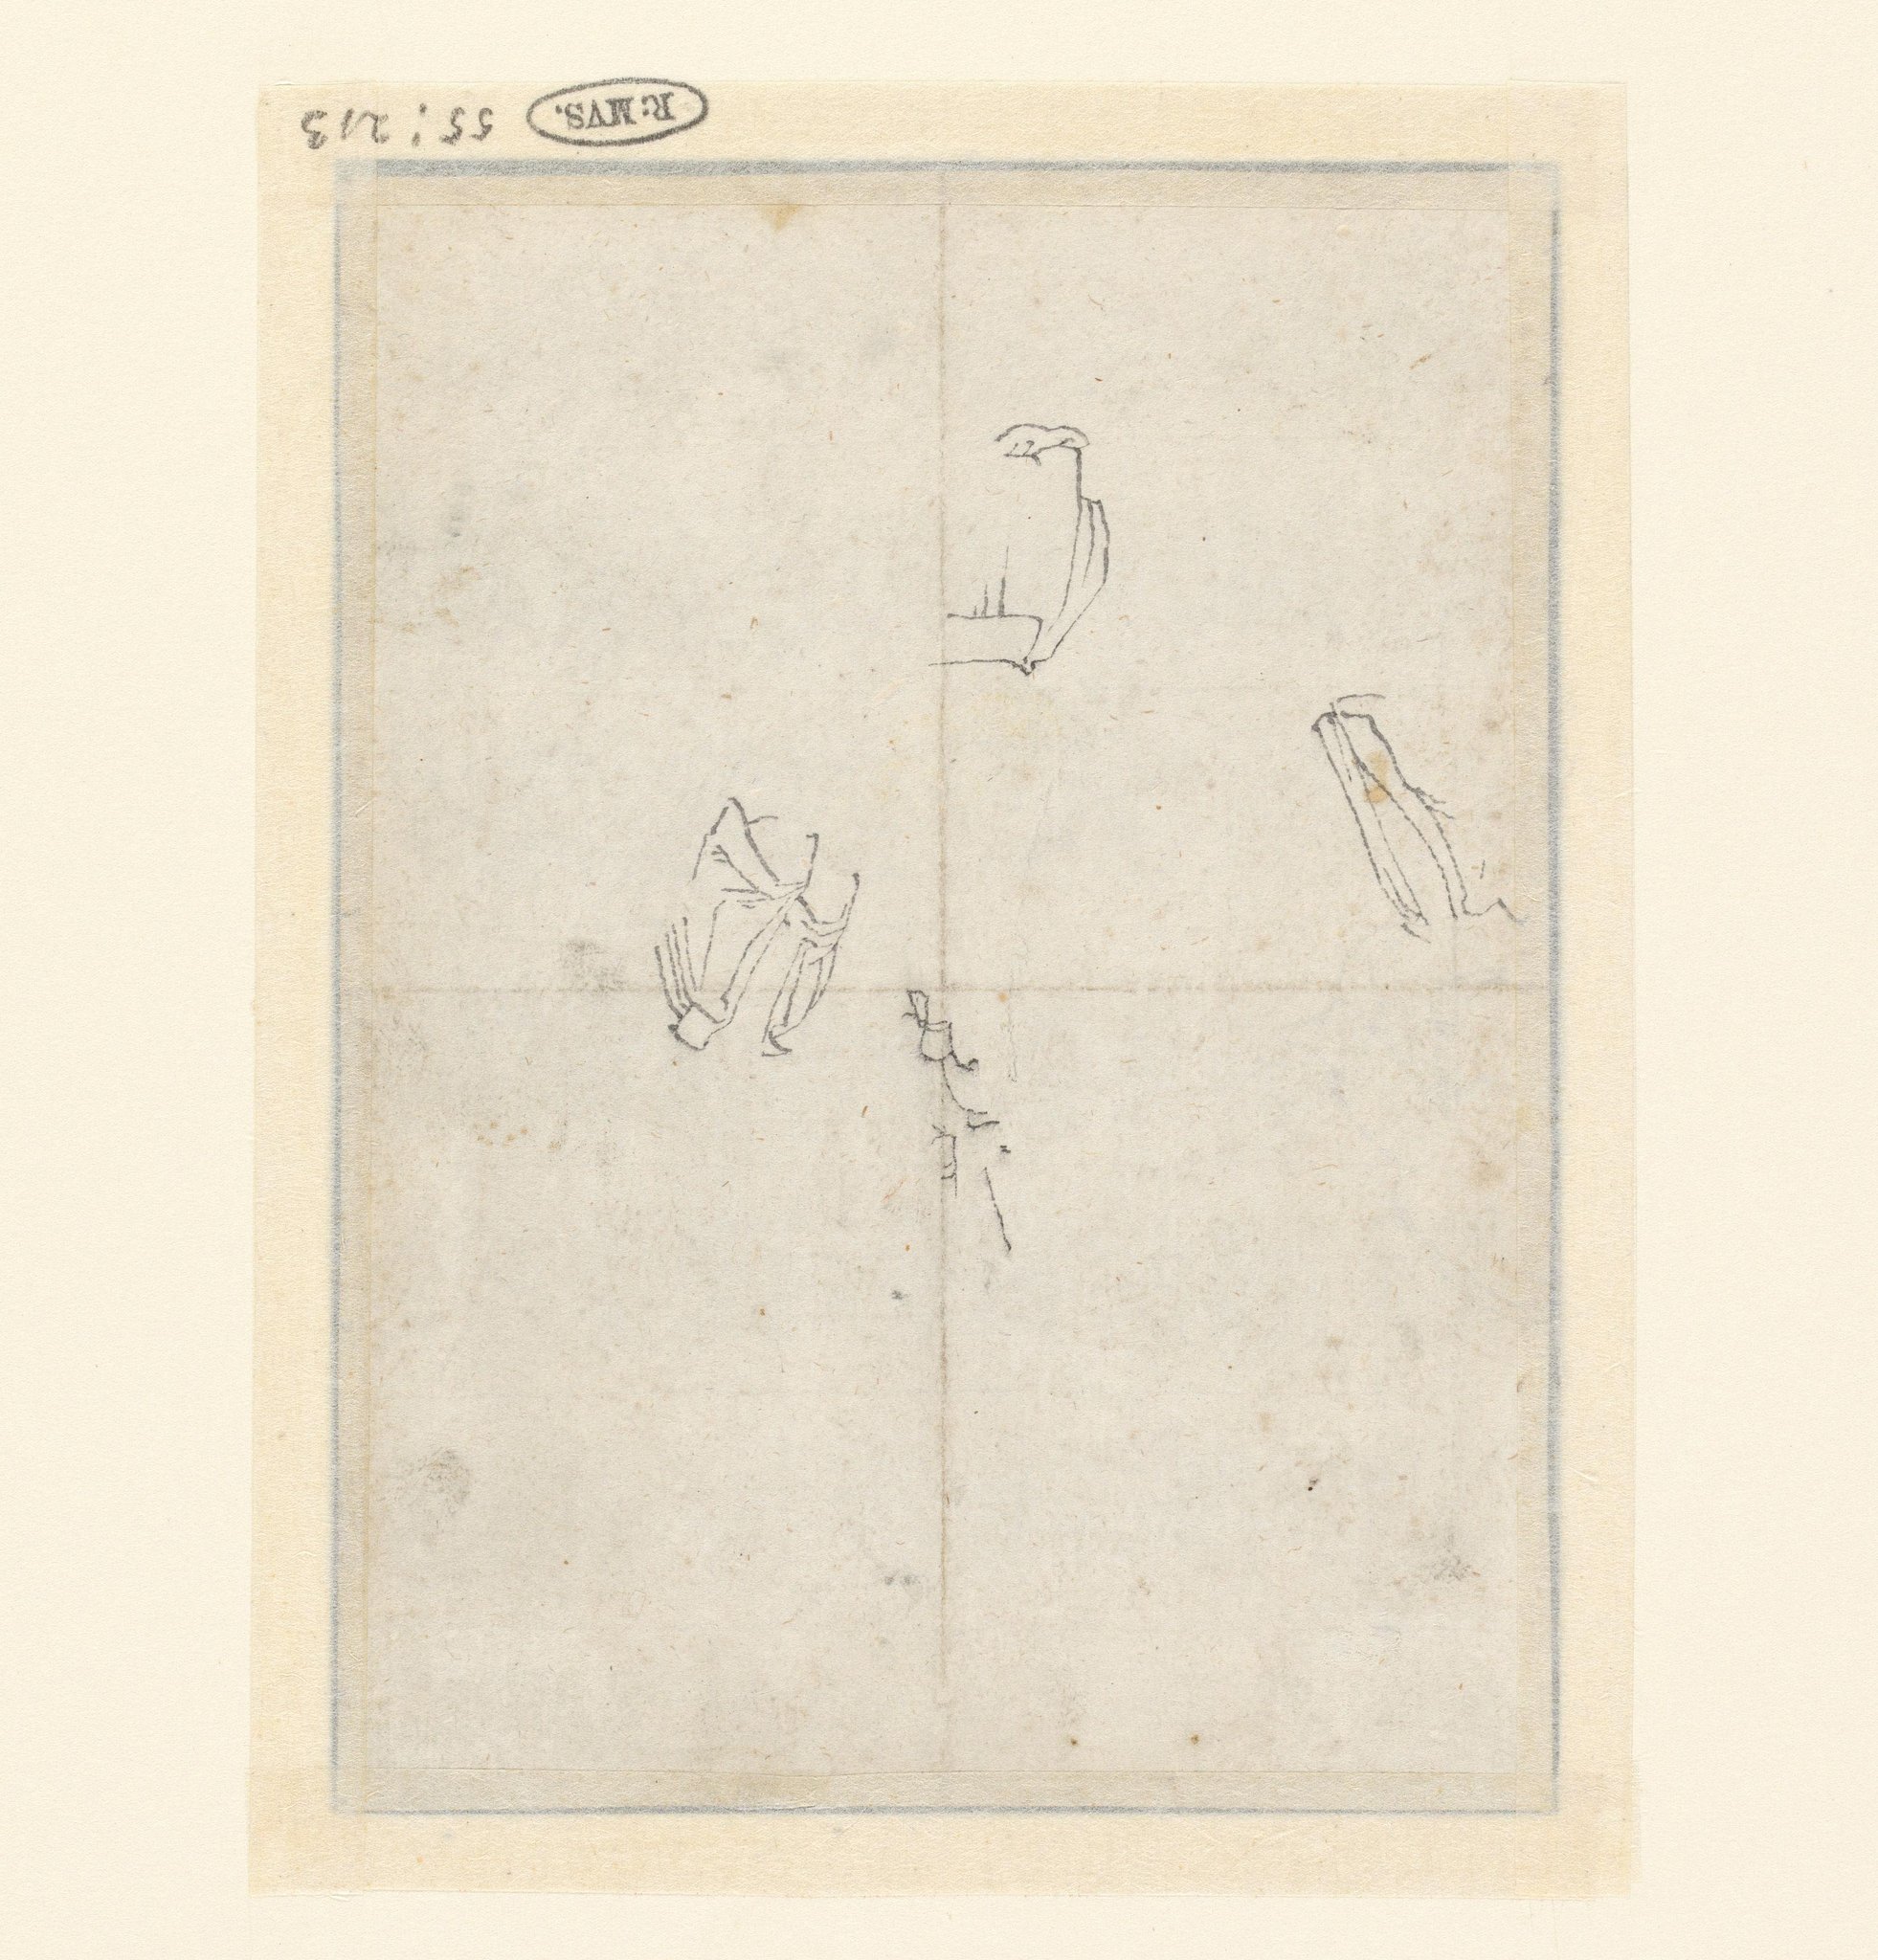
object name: drawing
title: Doorgetrokken contouren van de recto-voorstelling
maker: johann heinrich düntz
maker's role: draughtsman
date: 1631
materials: ink, paper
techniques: pen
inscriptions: date: ‘1631’